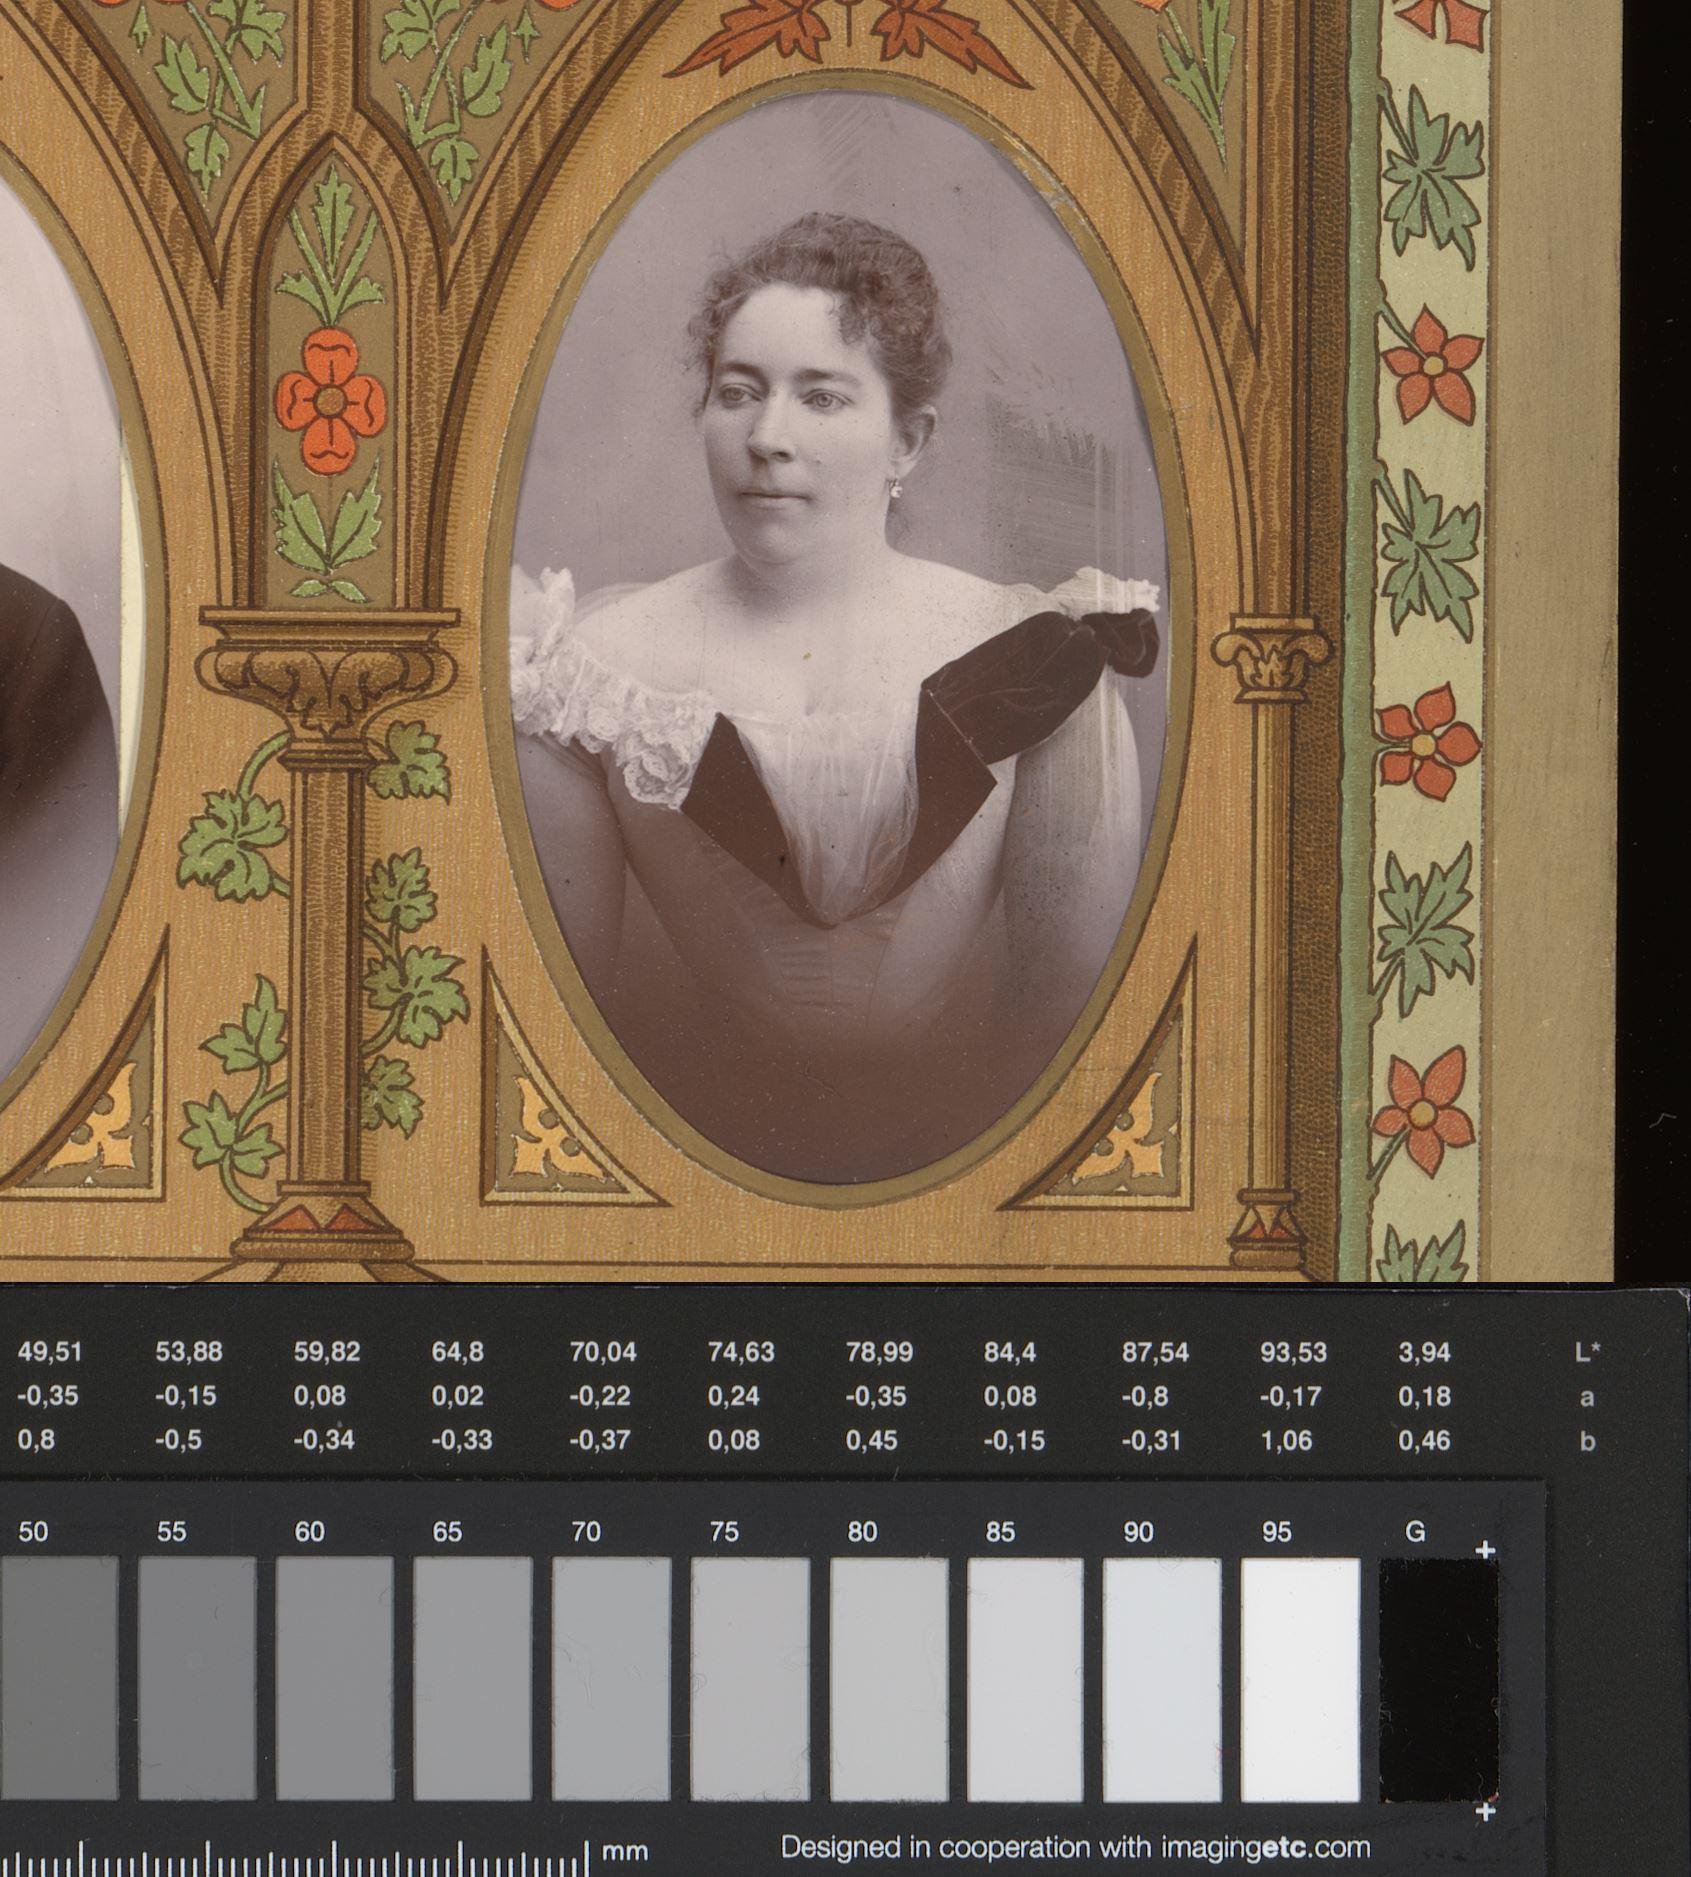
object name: photograph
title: Portret van een vrouw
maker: jules mazillier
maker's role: fotograaf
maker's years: 1859-1904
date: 1882-1940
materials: cardboard, photographic support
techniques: gelatin silver print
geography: dijon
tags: historical persons - bb - woman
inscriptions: inscription: ‘Jules Mazillier/ 67, RUE CHABOT-CHARNY/ Dijon’